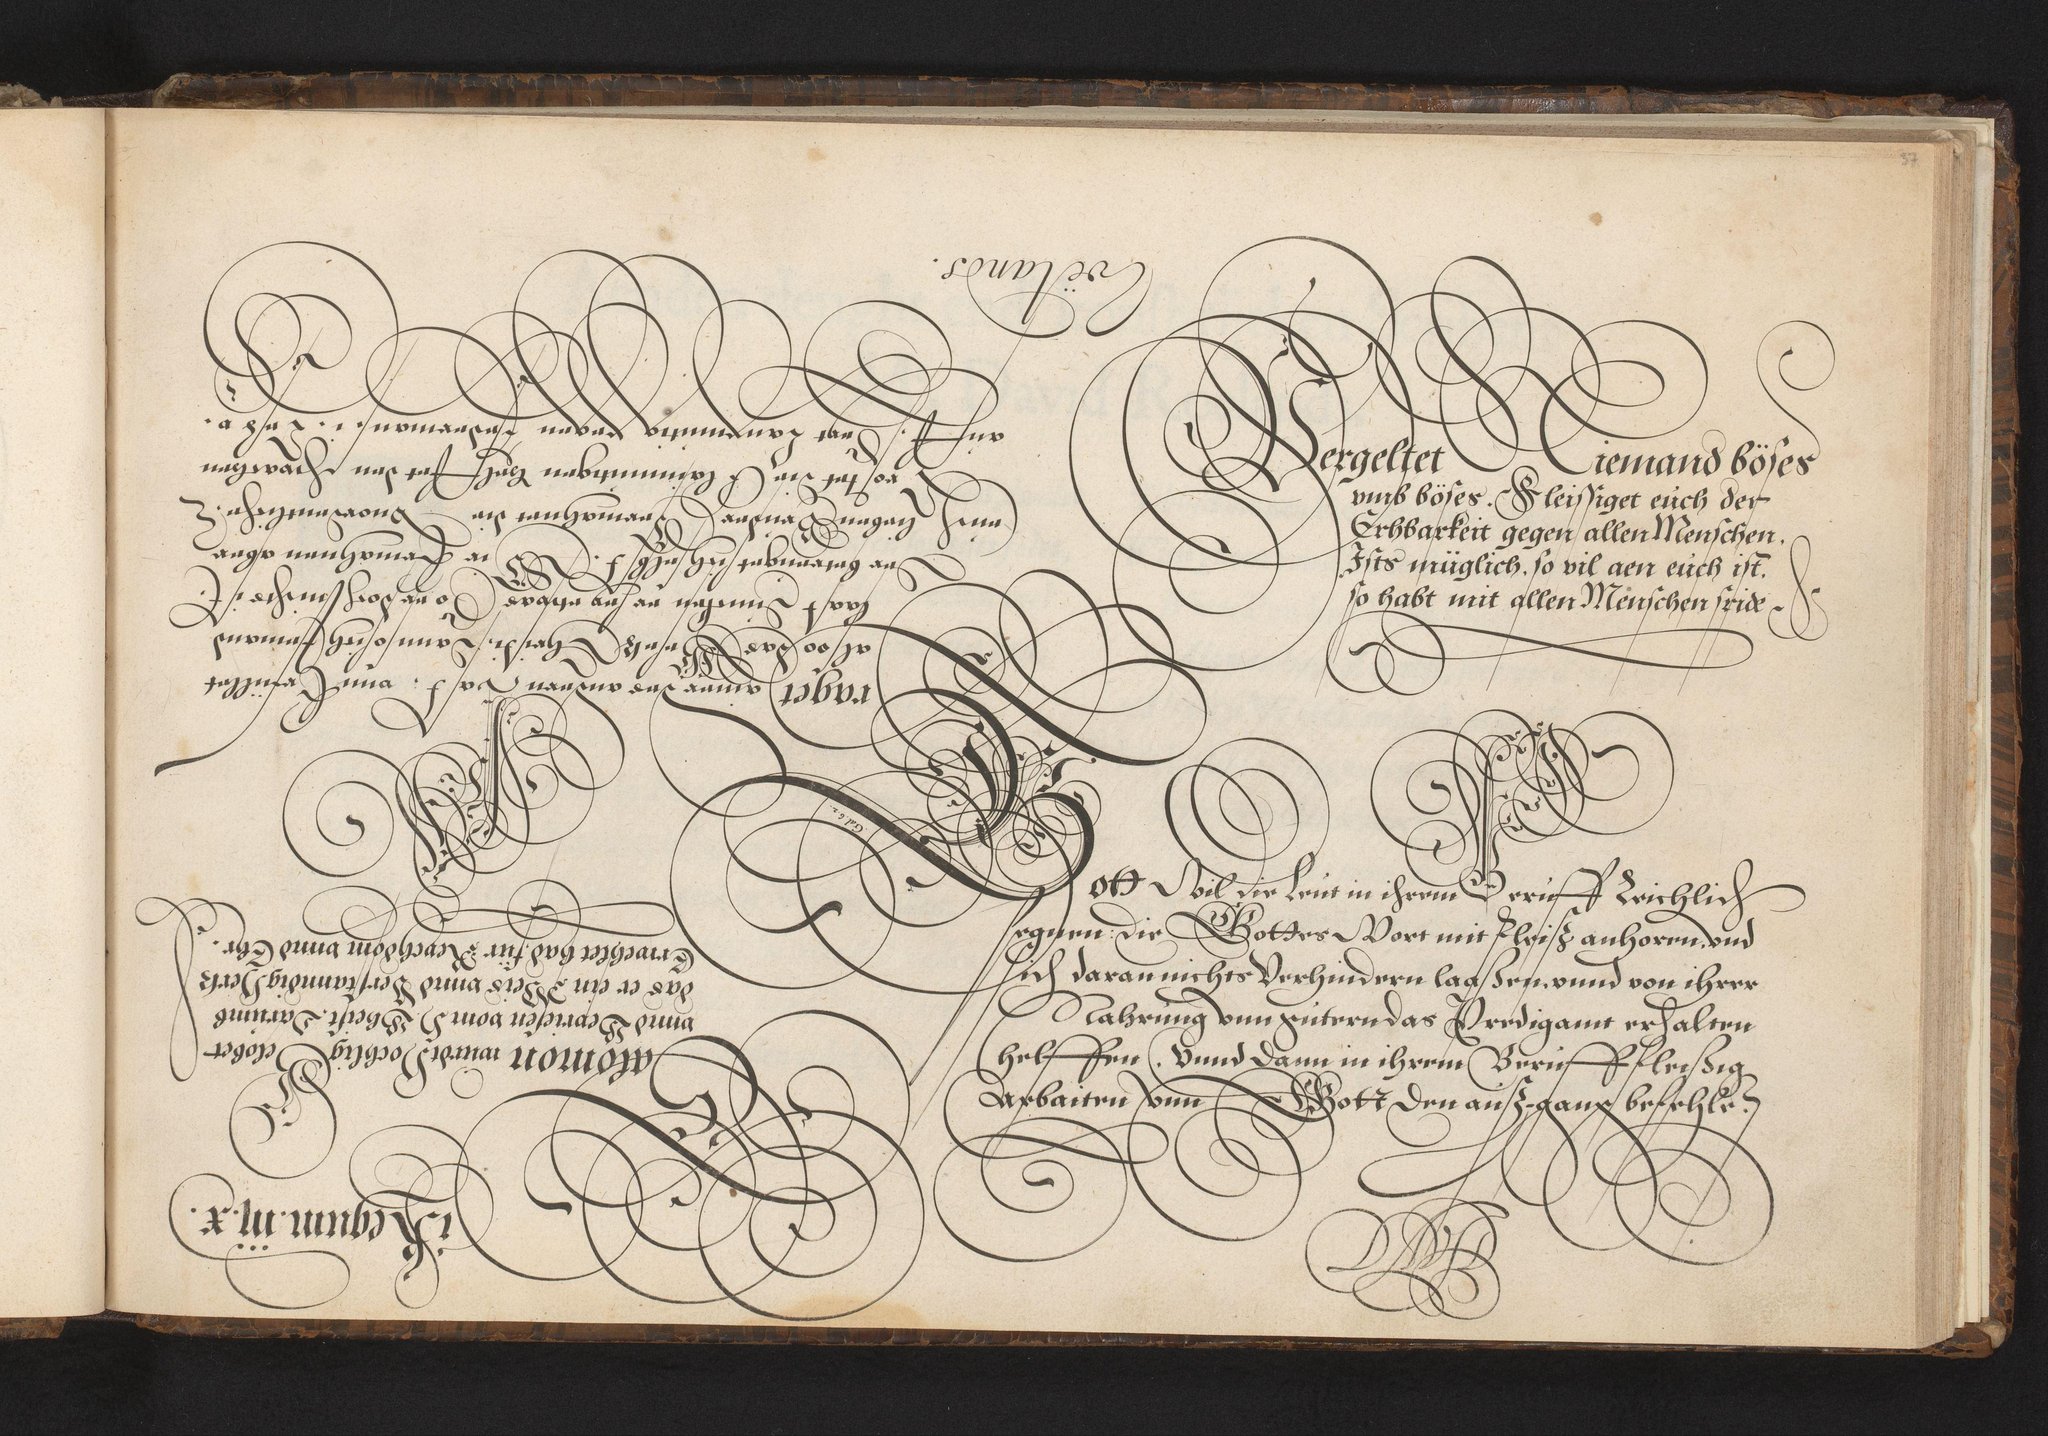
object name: album leaf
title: Schrijfvoorbeeld: Vergeldet Niemand böses (...)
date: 1616-1617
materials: paper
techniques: engraving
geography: flushing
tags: calligraphy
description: Schrijfvoorbeeld met vier blokken tekst in het Duits. De linkerhelft staat ondersteboven. Rechtsboven: Vergeldet Niemand böses ... De prent maakt deel uit van een album.